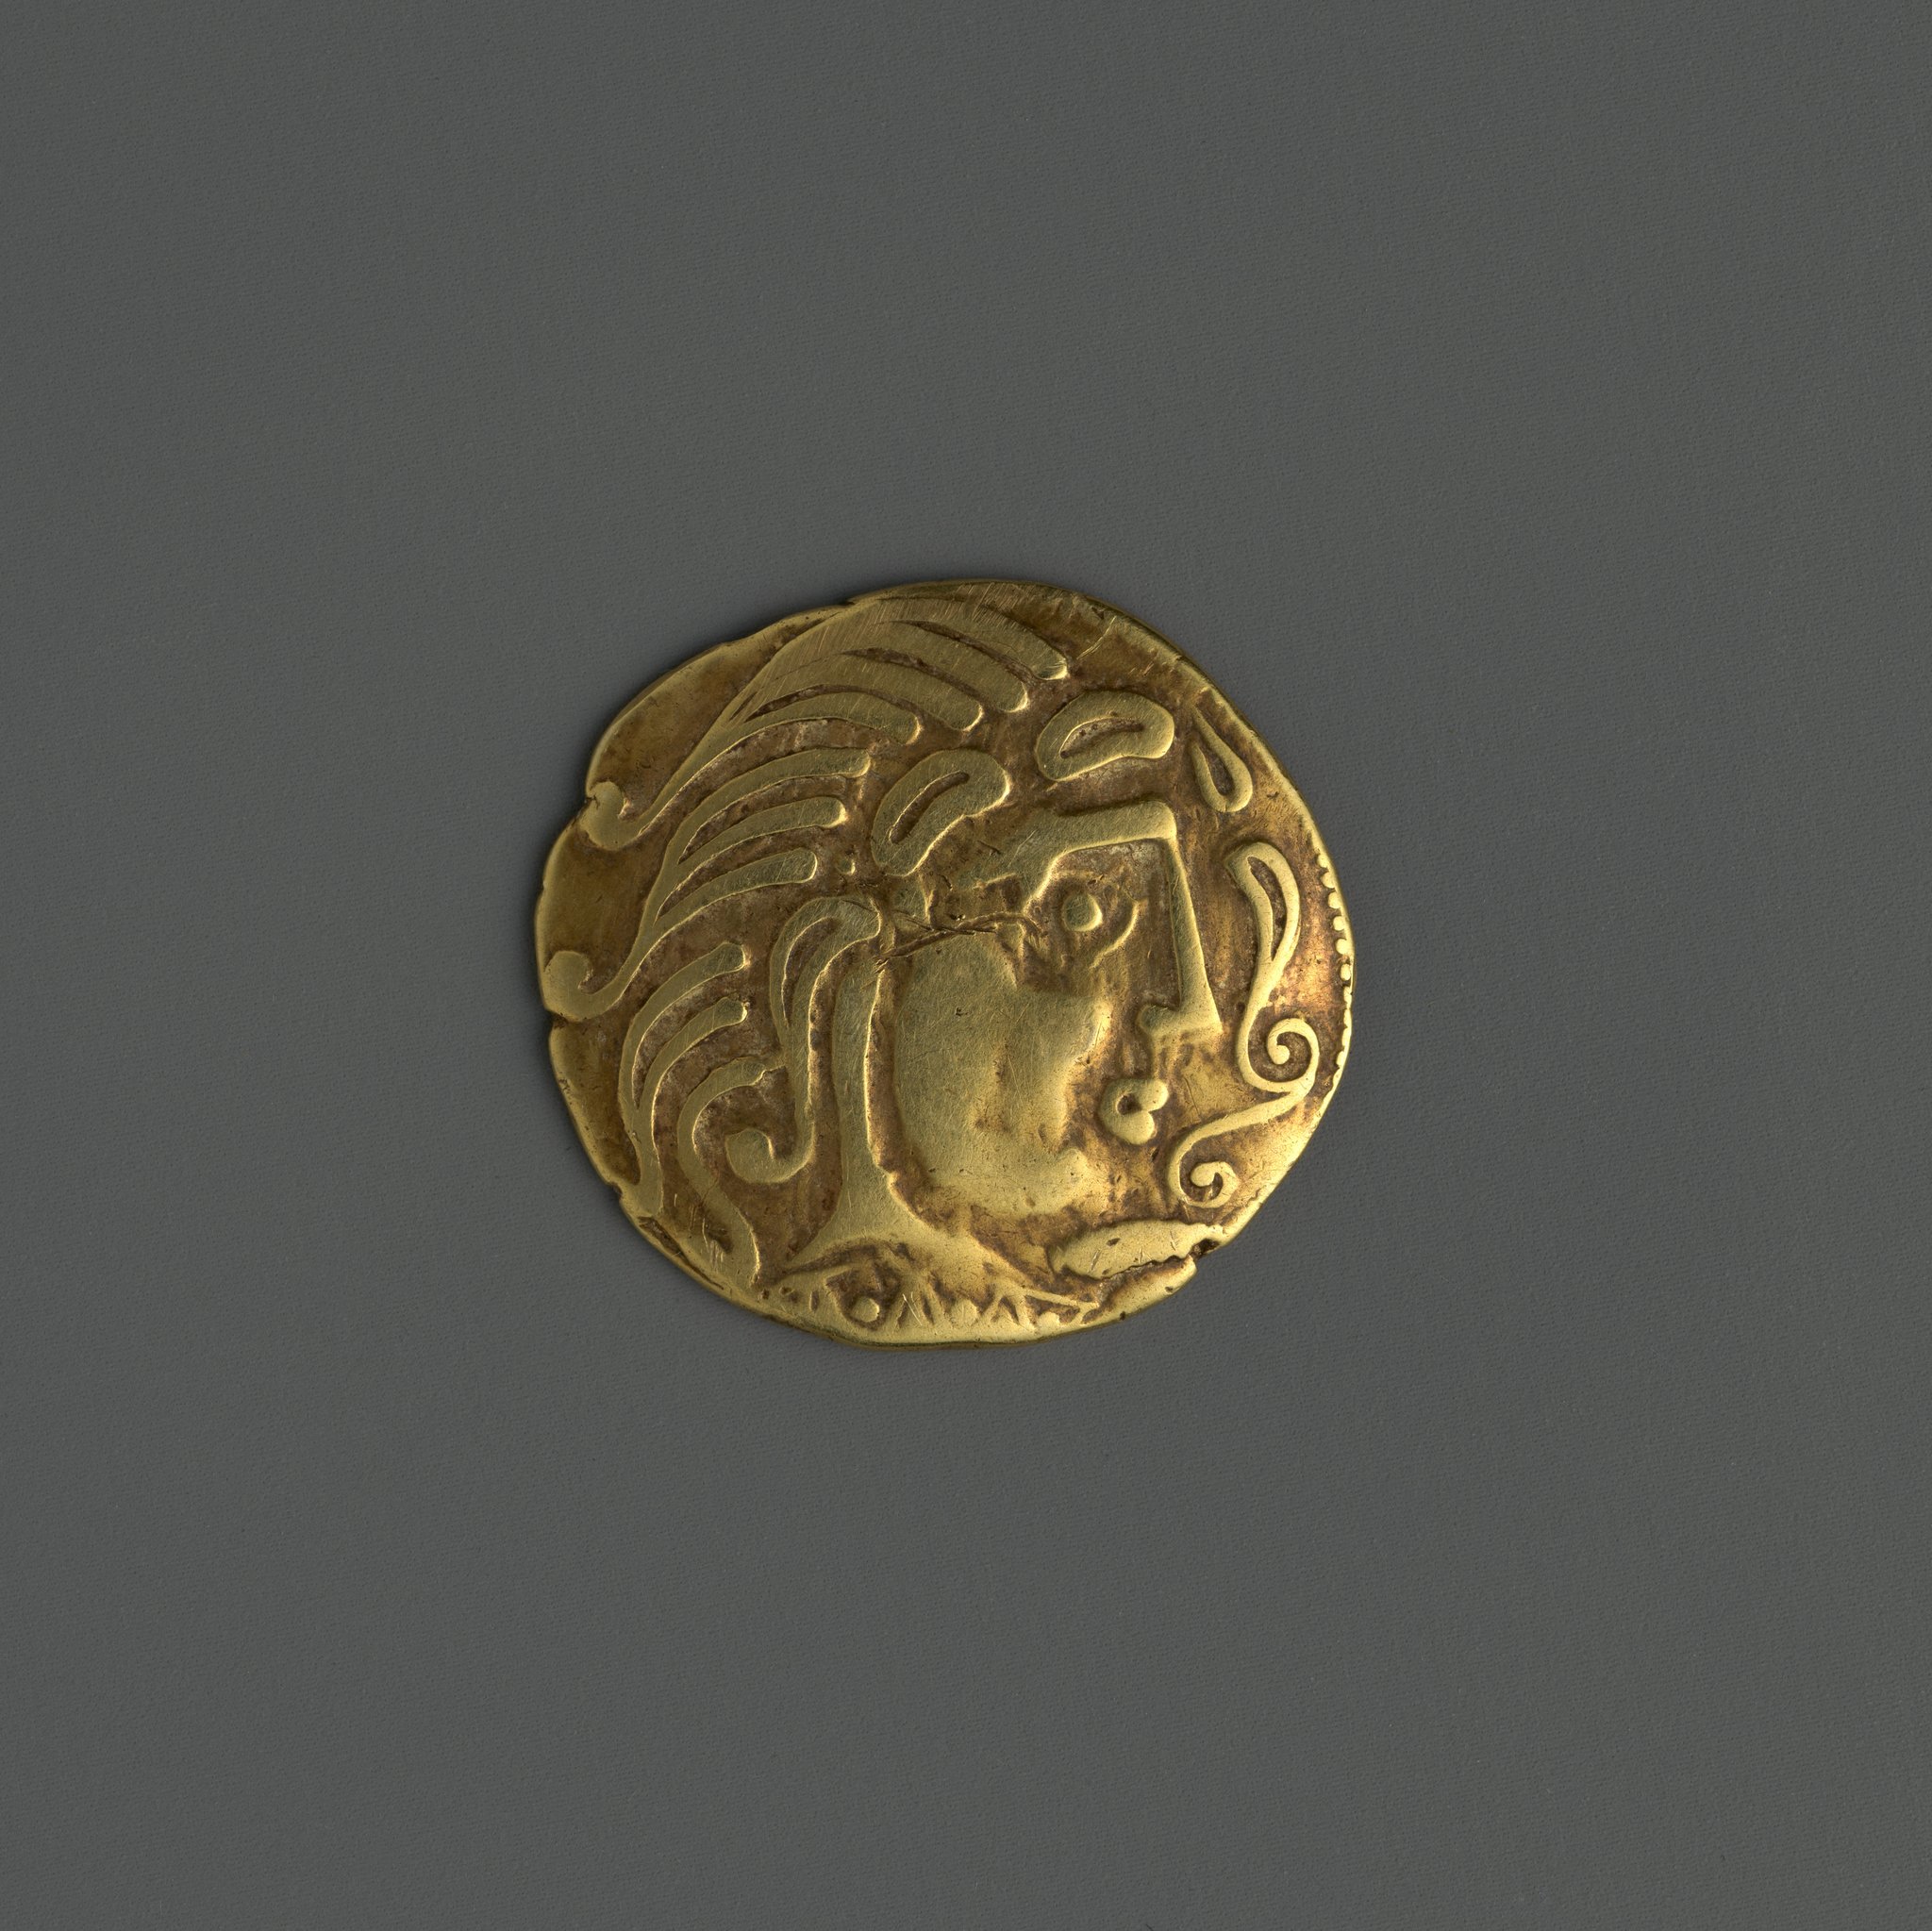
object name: coin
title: Gold Coin of the Parisii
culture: celtic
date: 125-101 BCE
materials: gold